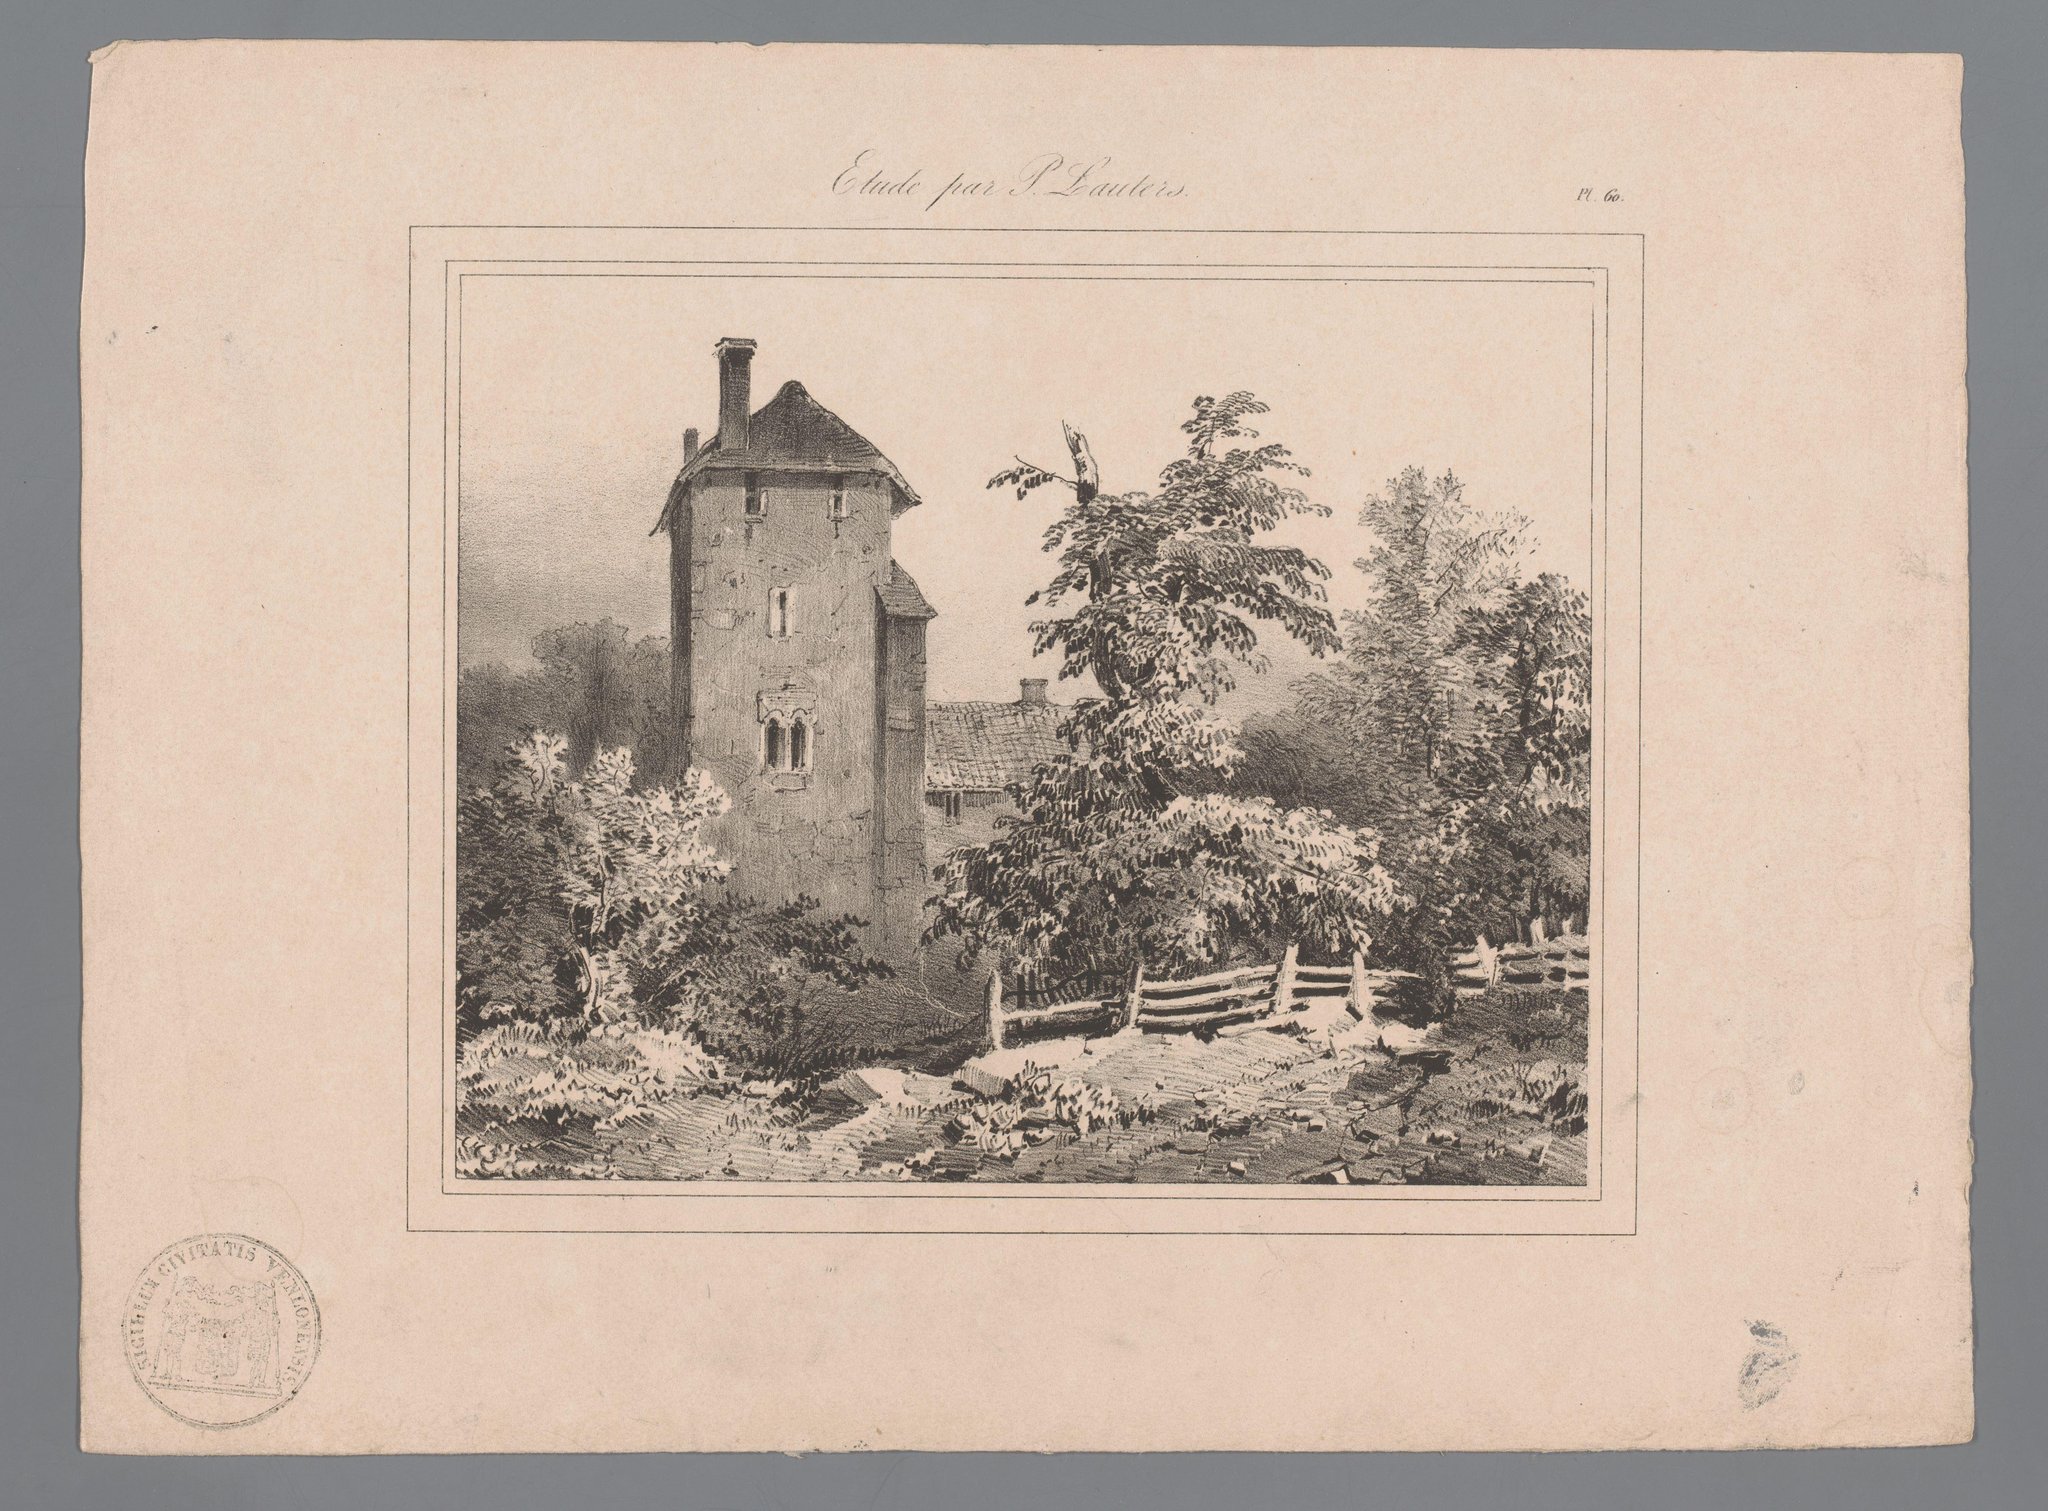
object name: print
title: Landschappen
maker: paulus lauters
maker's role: print maker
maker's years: 1806-1875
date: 1832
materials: paper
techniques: lithograph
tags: forest, wood, landscape with tower or castle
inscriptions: collector's mark: Lugt 2228, collector's mark: ‘Sigillum Civitatis Venlonessis’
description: Prent maakt deel uit van een serie landschappen van een onbekend aantal prenten. De hoogst genummerde prent uit deze serie in de collectie Rijksmuseum Amsterdam heeft nummer 74.